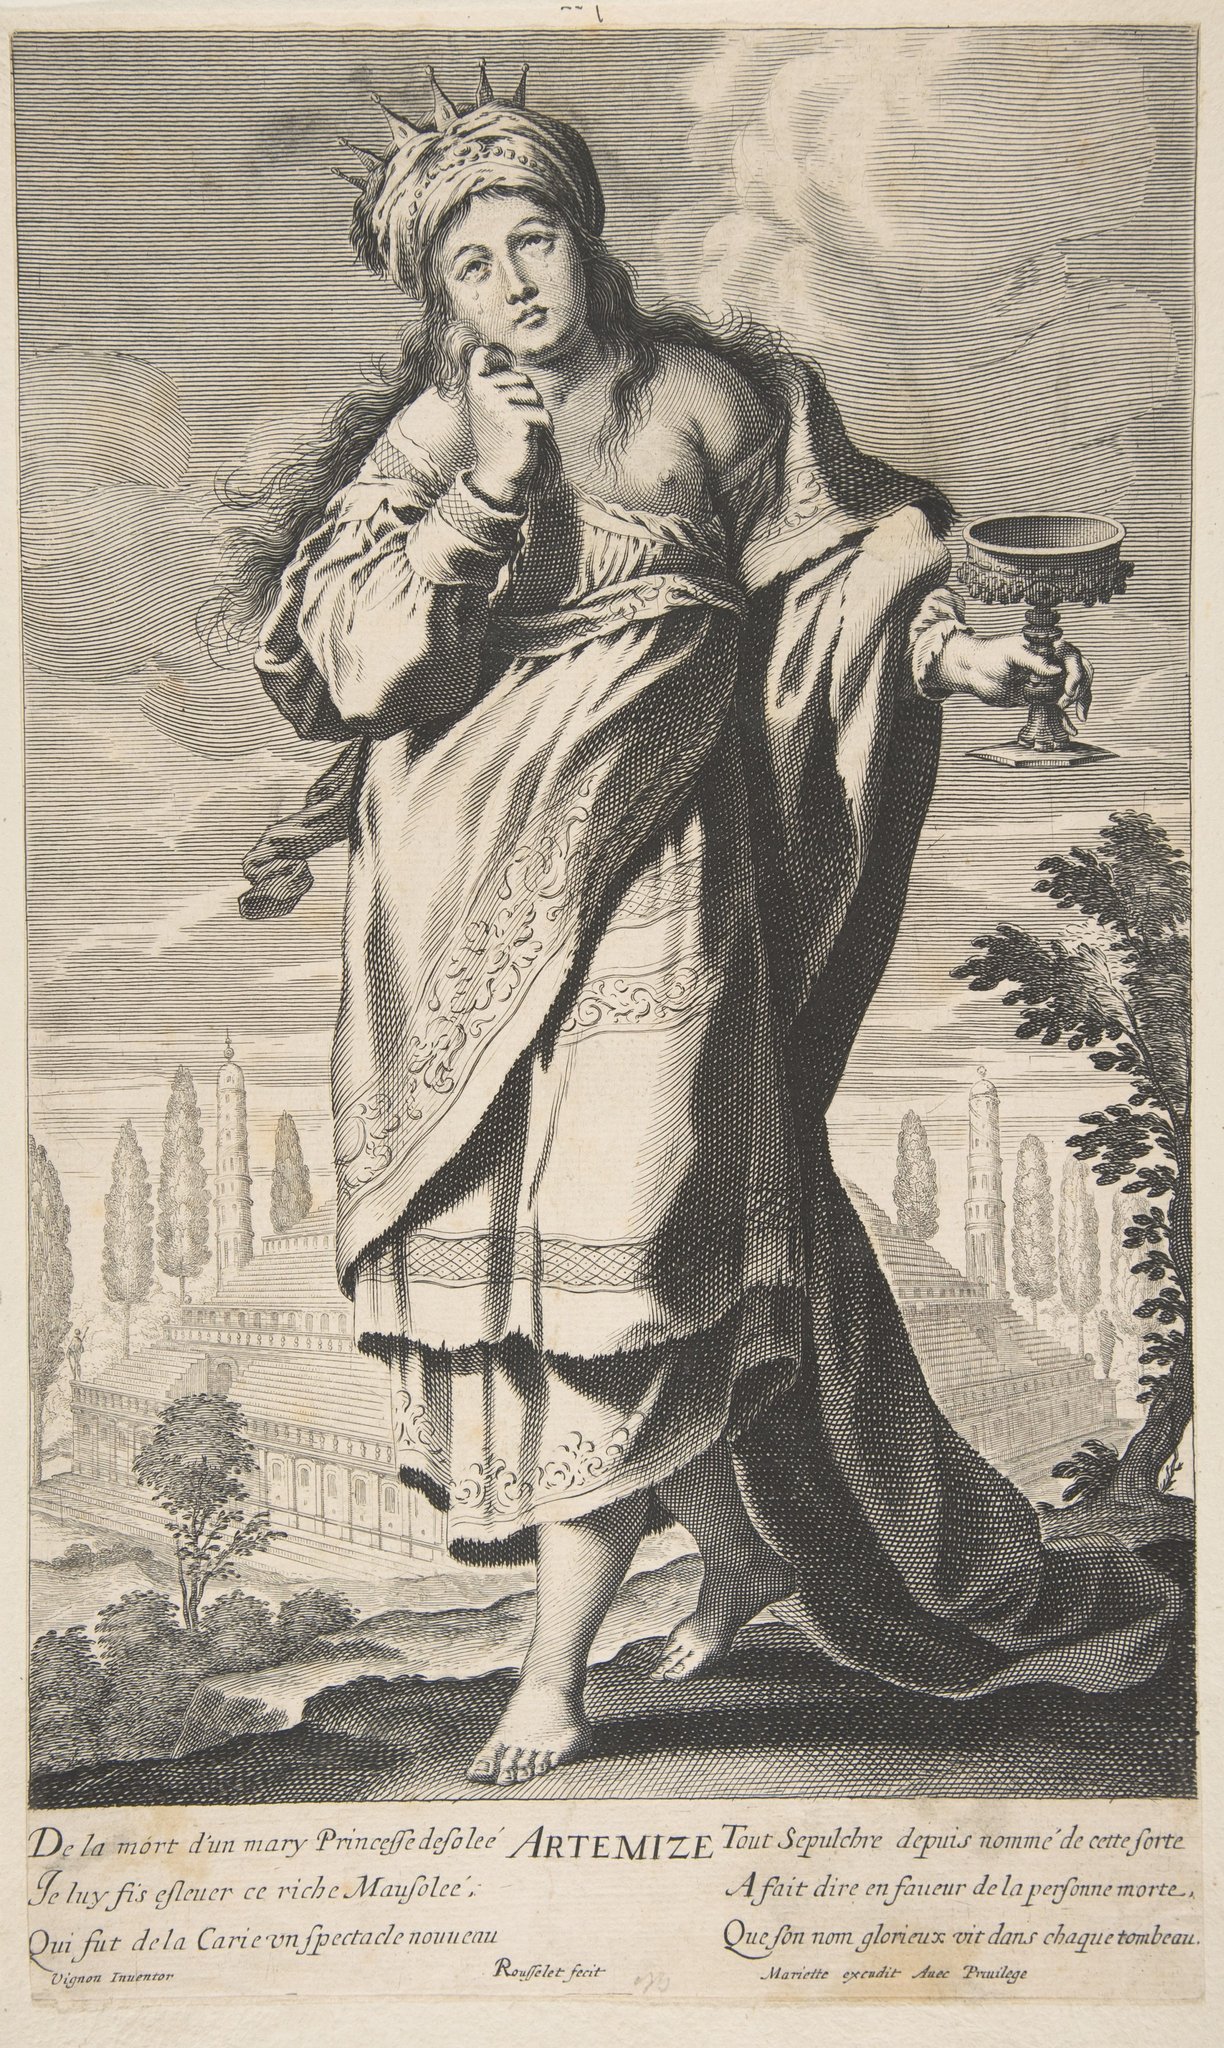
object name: print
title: Artémise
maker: gilles rousselet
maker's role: artist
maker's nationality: french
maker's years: 1614-1686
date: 1639-1640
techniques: engraving, etching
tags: queens